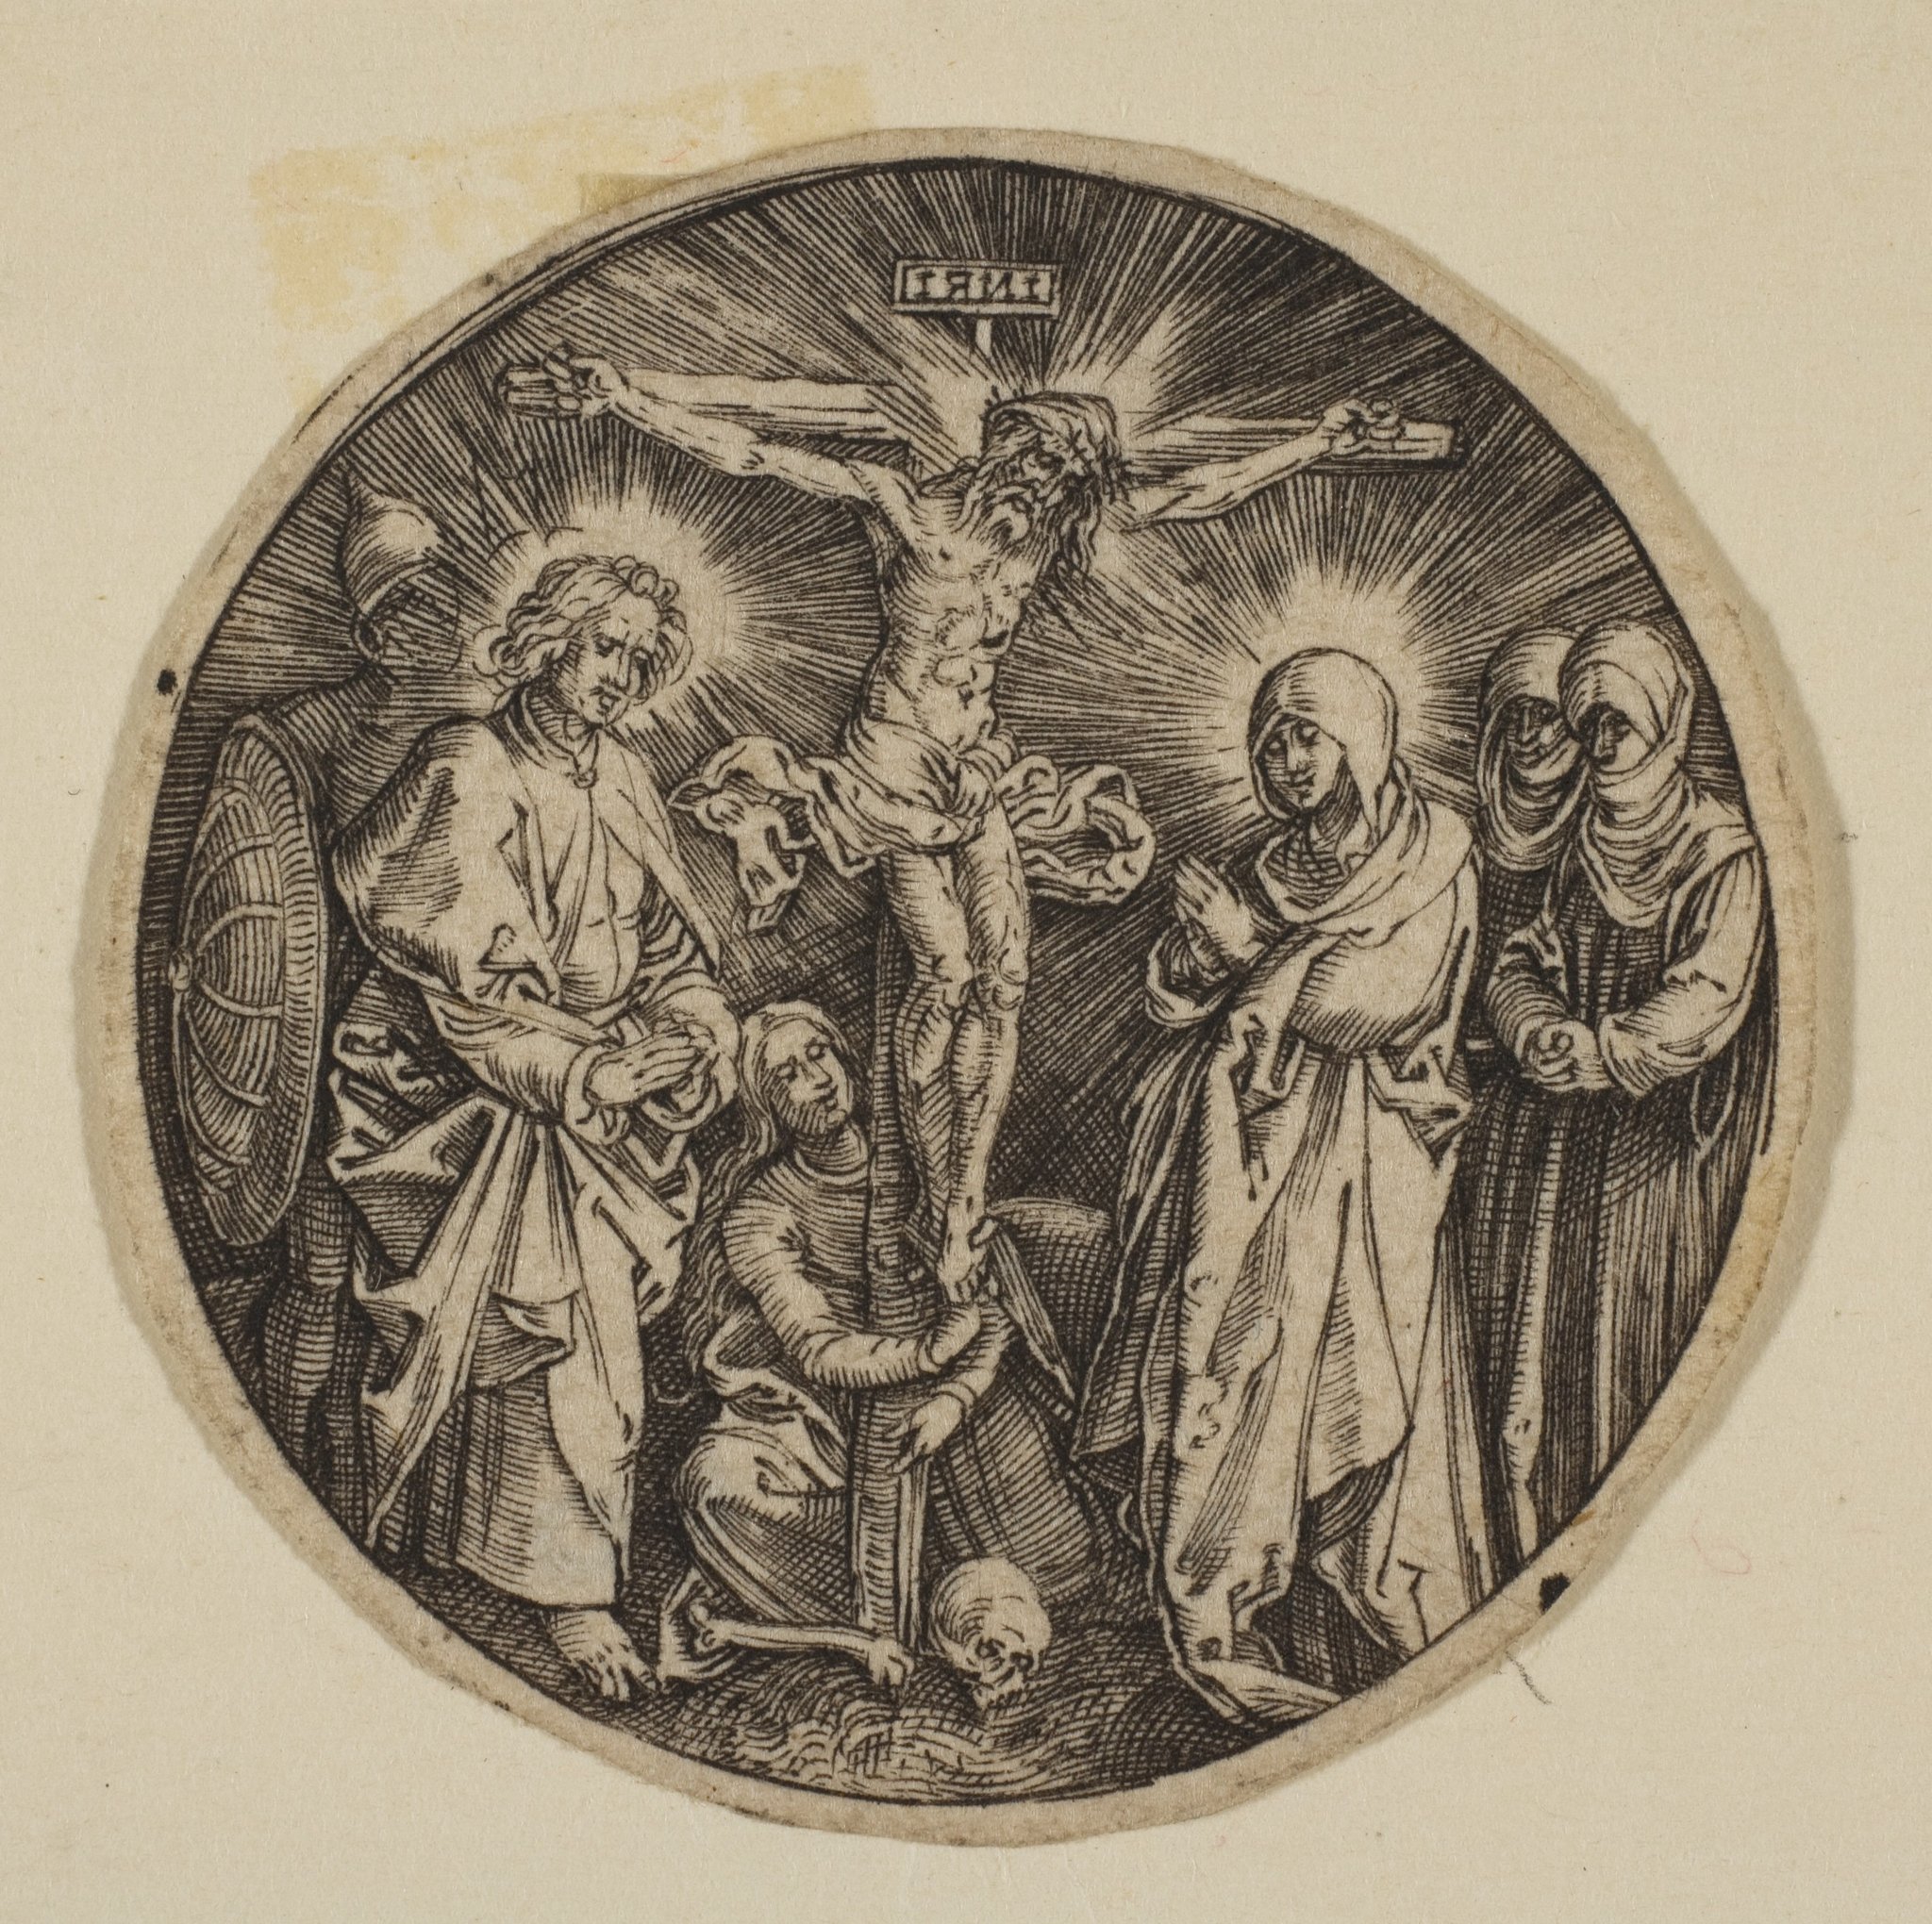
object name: print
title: The Crucifixion (Round) (copy)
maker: albrecht dürer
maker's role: artist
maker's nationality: german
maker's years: 1471-1528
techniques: engraving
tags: sadness,christ,mary magdalene,virgin mary,crucifixion